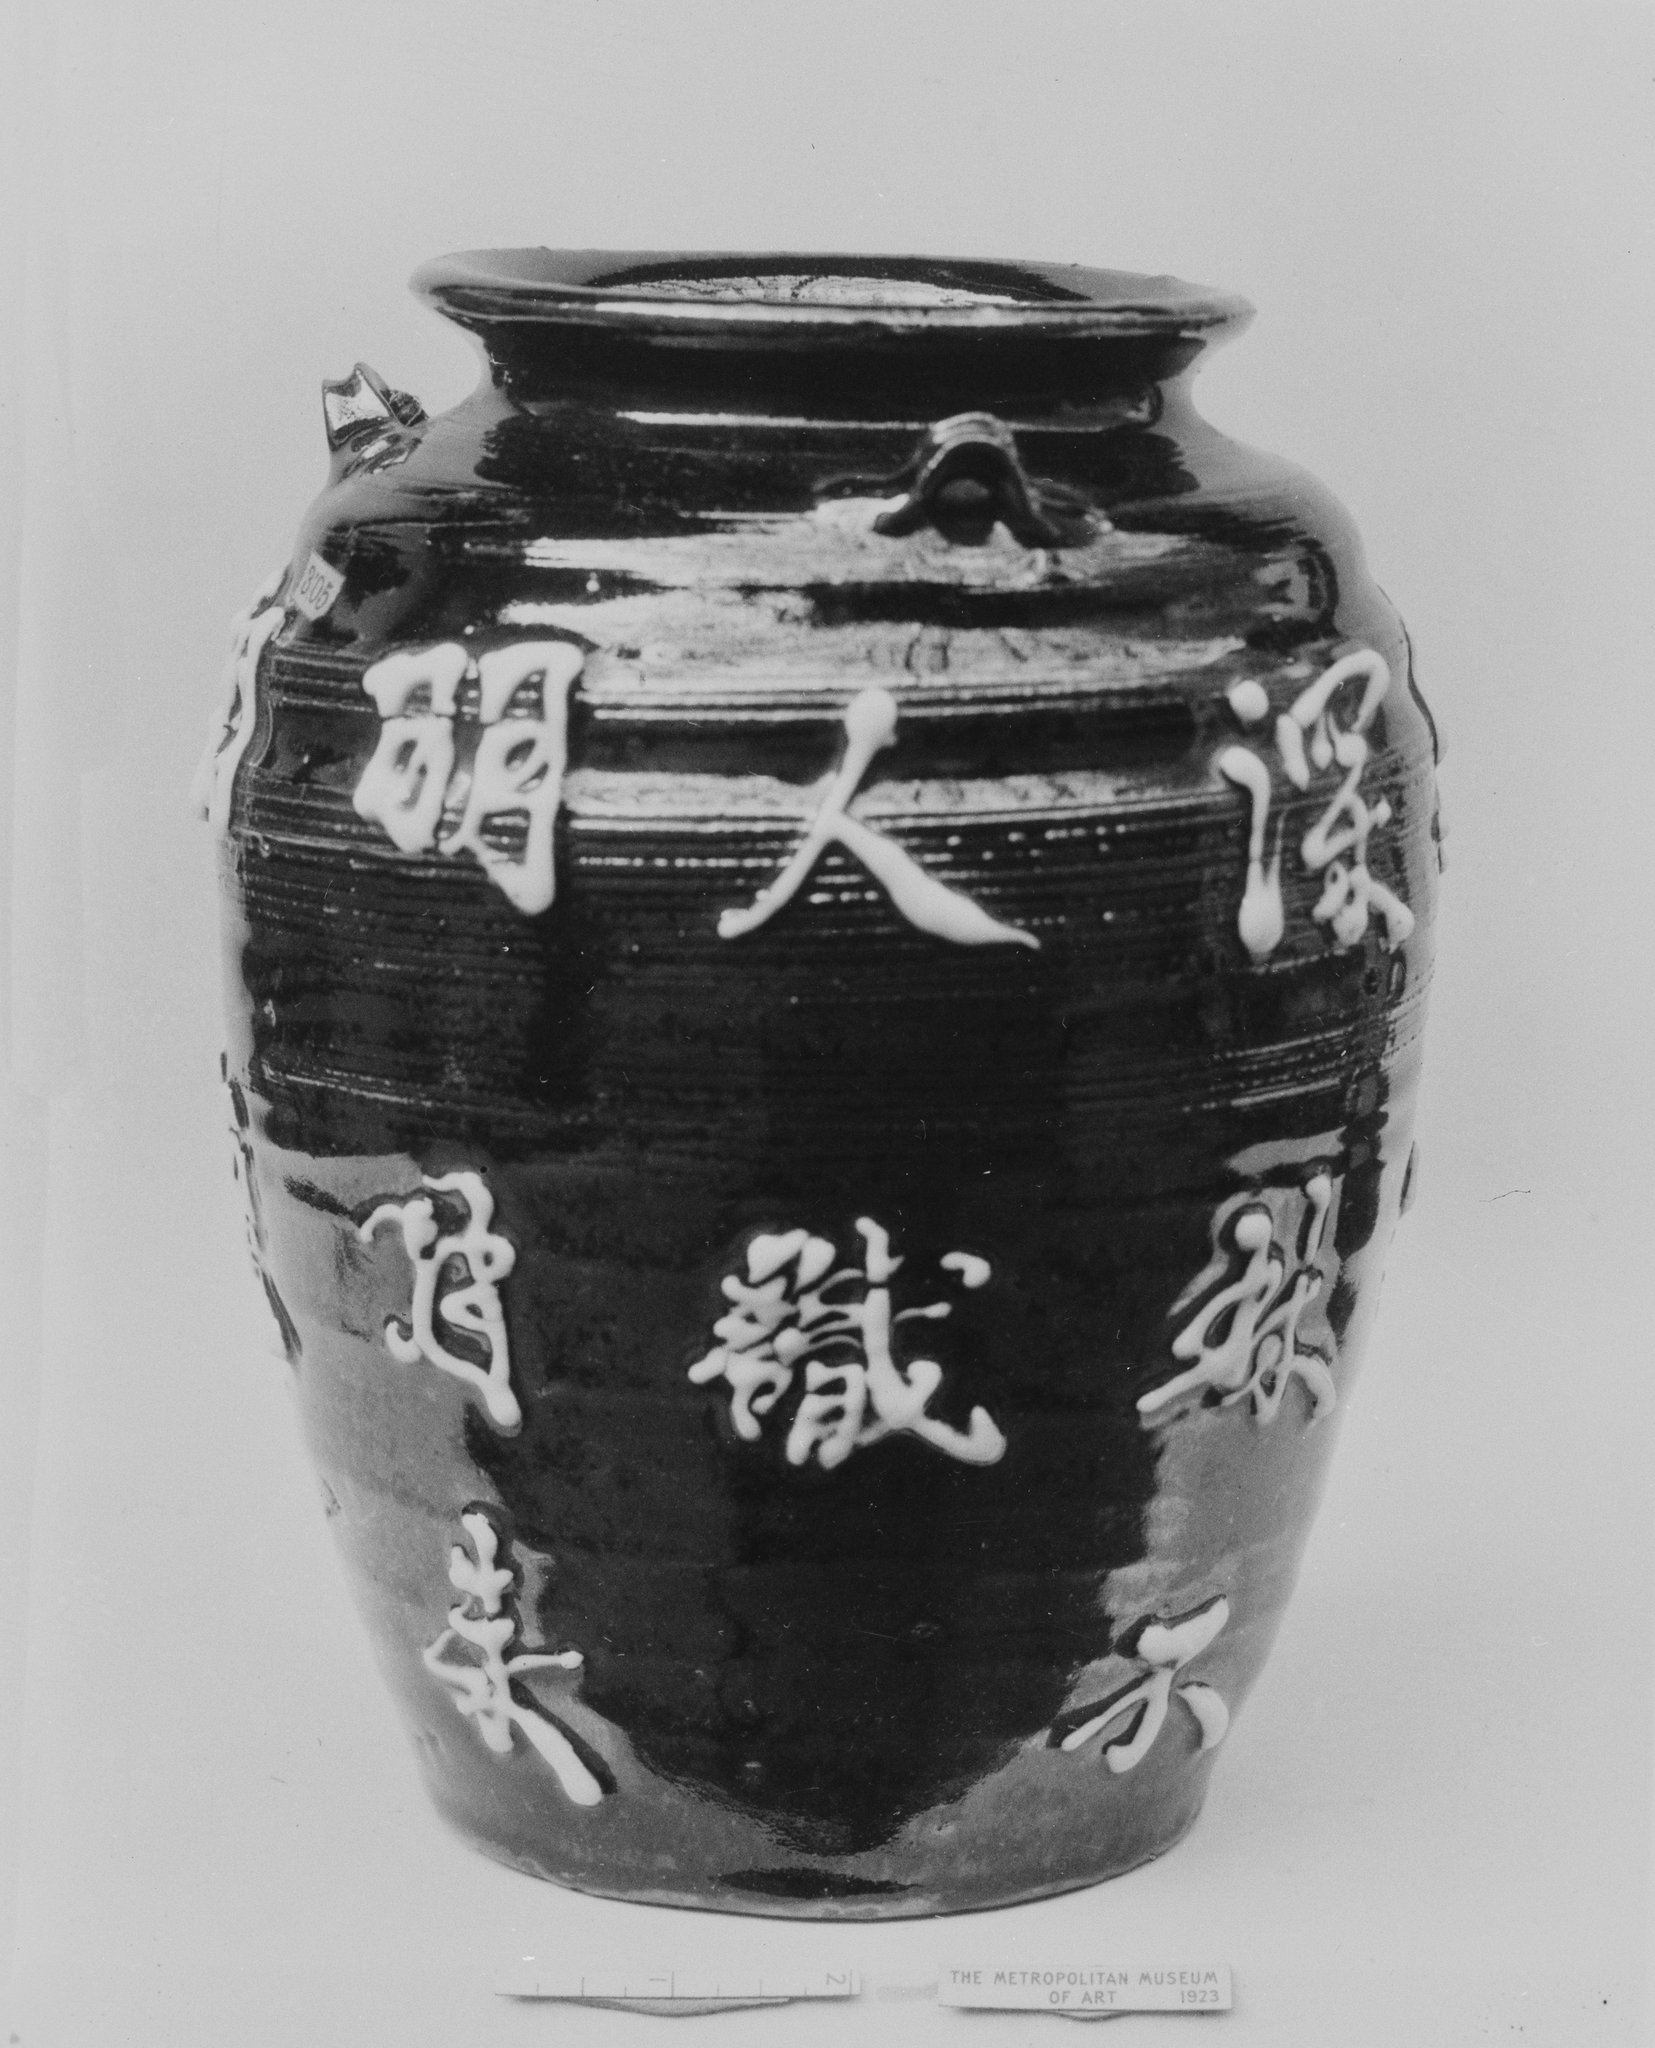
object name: jar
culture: japanese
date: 1850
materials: glaze, stoneware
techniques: relief